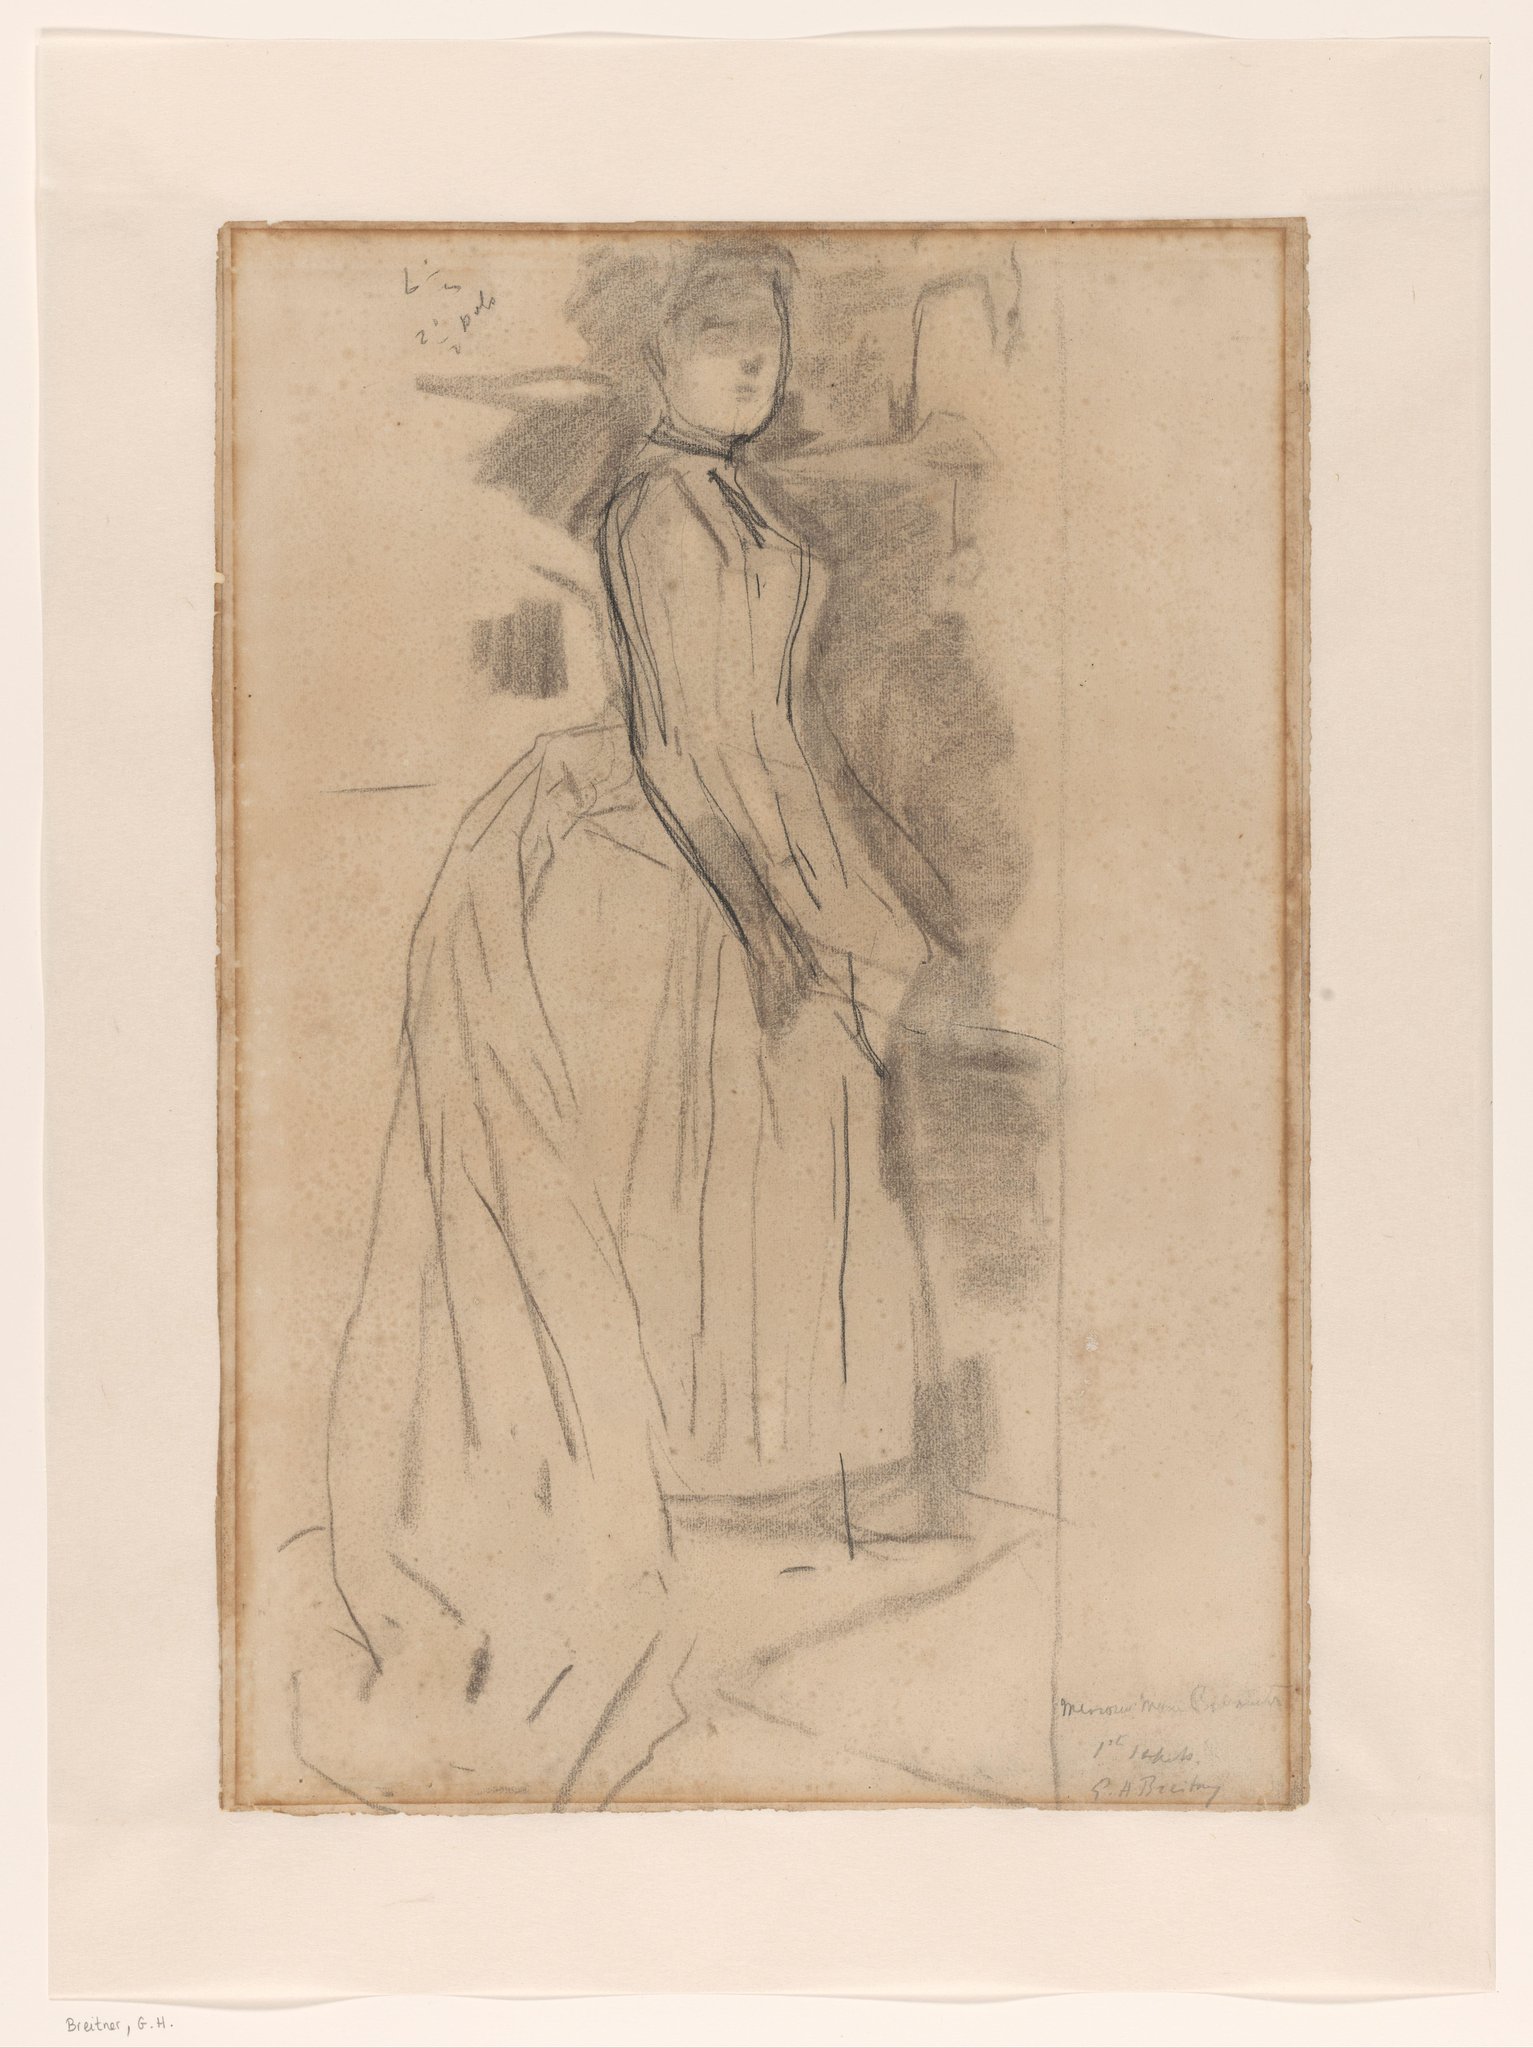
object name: drawing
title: Mevrouw Mann Bouwmeester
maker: george hendrik breitner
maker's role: draughtsman, painter, print maker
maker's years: 1857-1923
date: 1887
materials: chalk, charcoal, paper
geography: amsterdam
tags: historical persons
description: Studie voor het portret van de actrice Theo Mann-Bouwmeester.